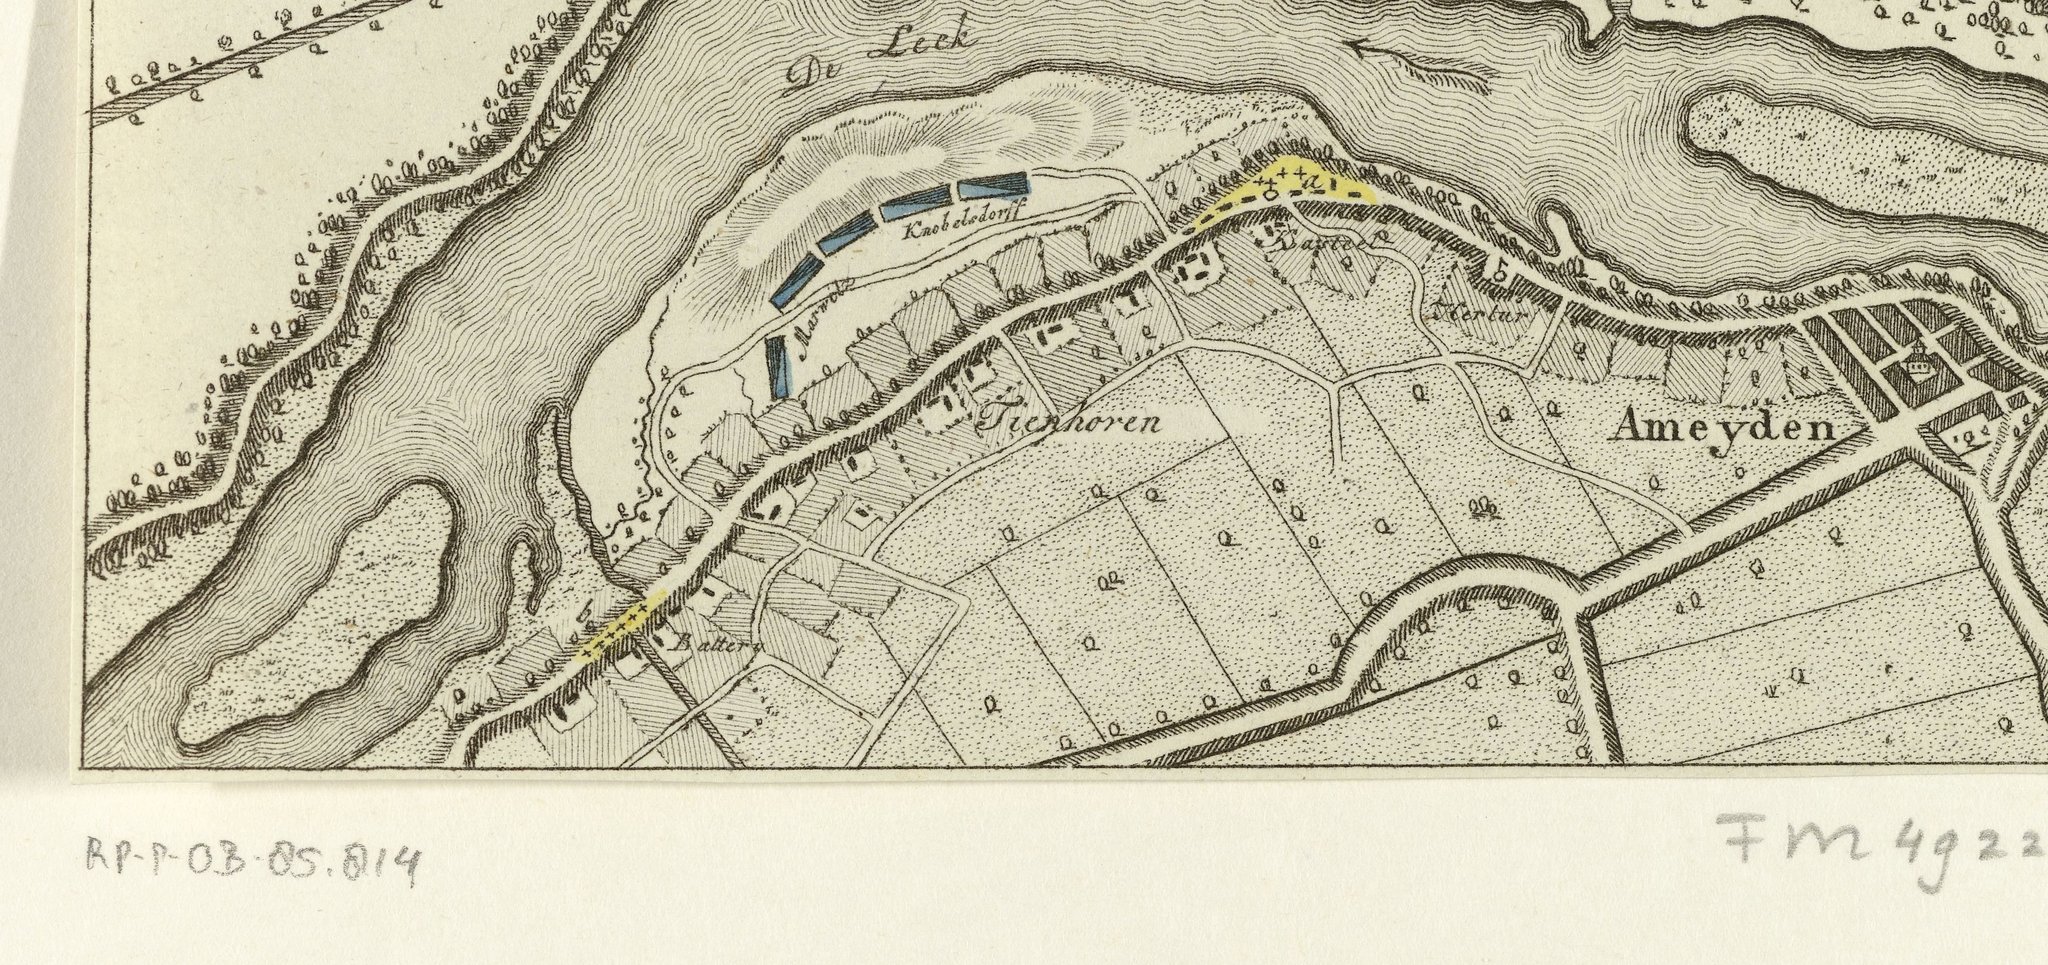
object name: map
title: No. 11. Camp te Tienhoven, den 18 September, 1787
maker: Anonymous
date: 1790-1792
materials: paper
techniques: etching, hand coloring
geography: northern netherlands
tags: maps of cities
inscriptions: collector's mark: Lugt 2228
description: Kaart met de ligging van het kampement van de Pruisische troepen bij Tienhoven op 18 september 1787. Onderdeel van een groep van veertien genummerde kaartjes van de kampementen van de Pruisische troepen tijdens de interventie in de Nederlanden in september 1787.